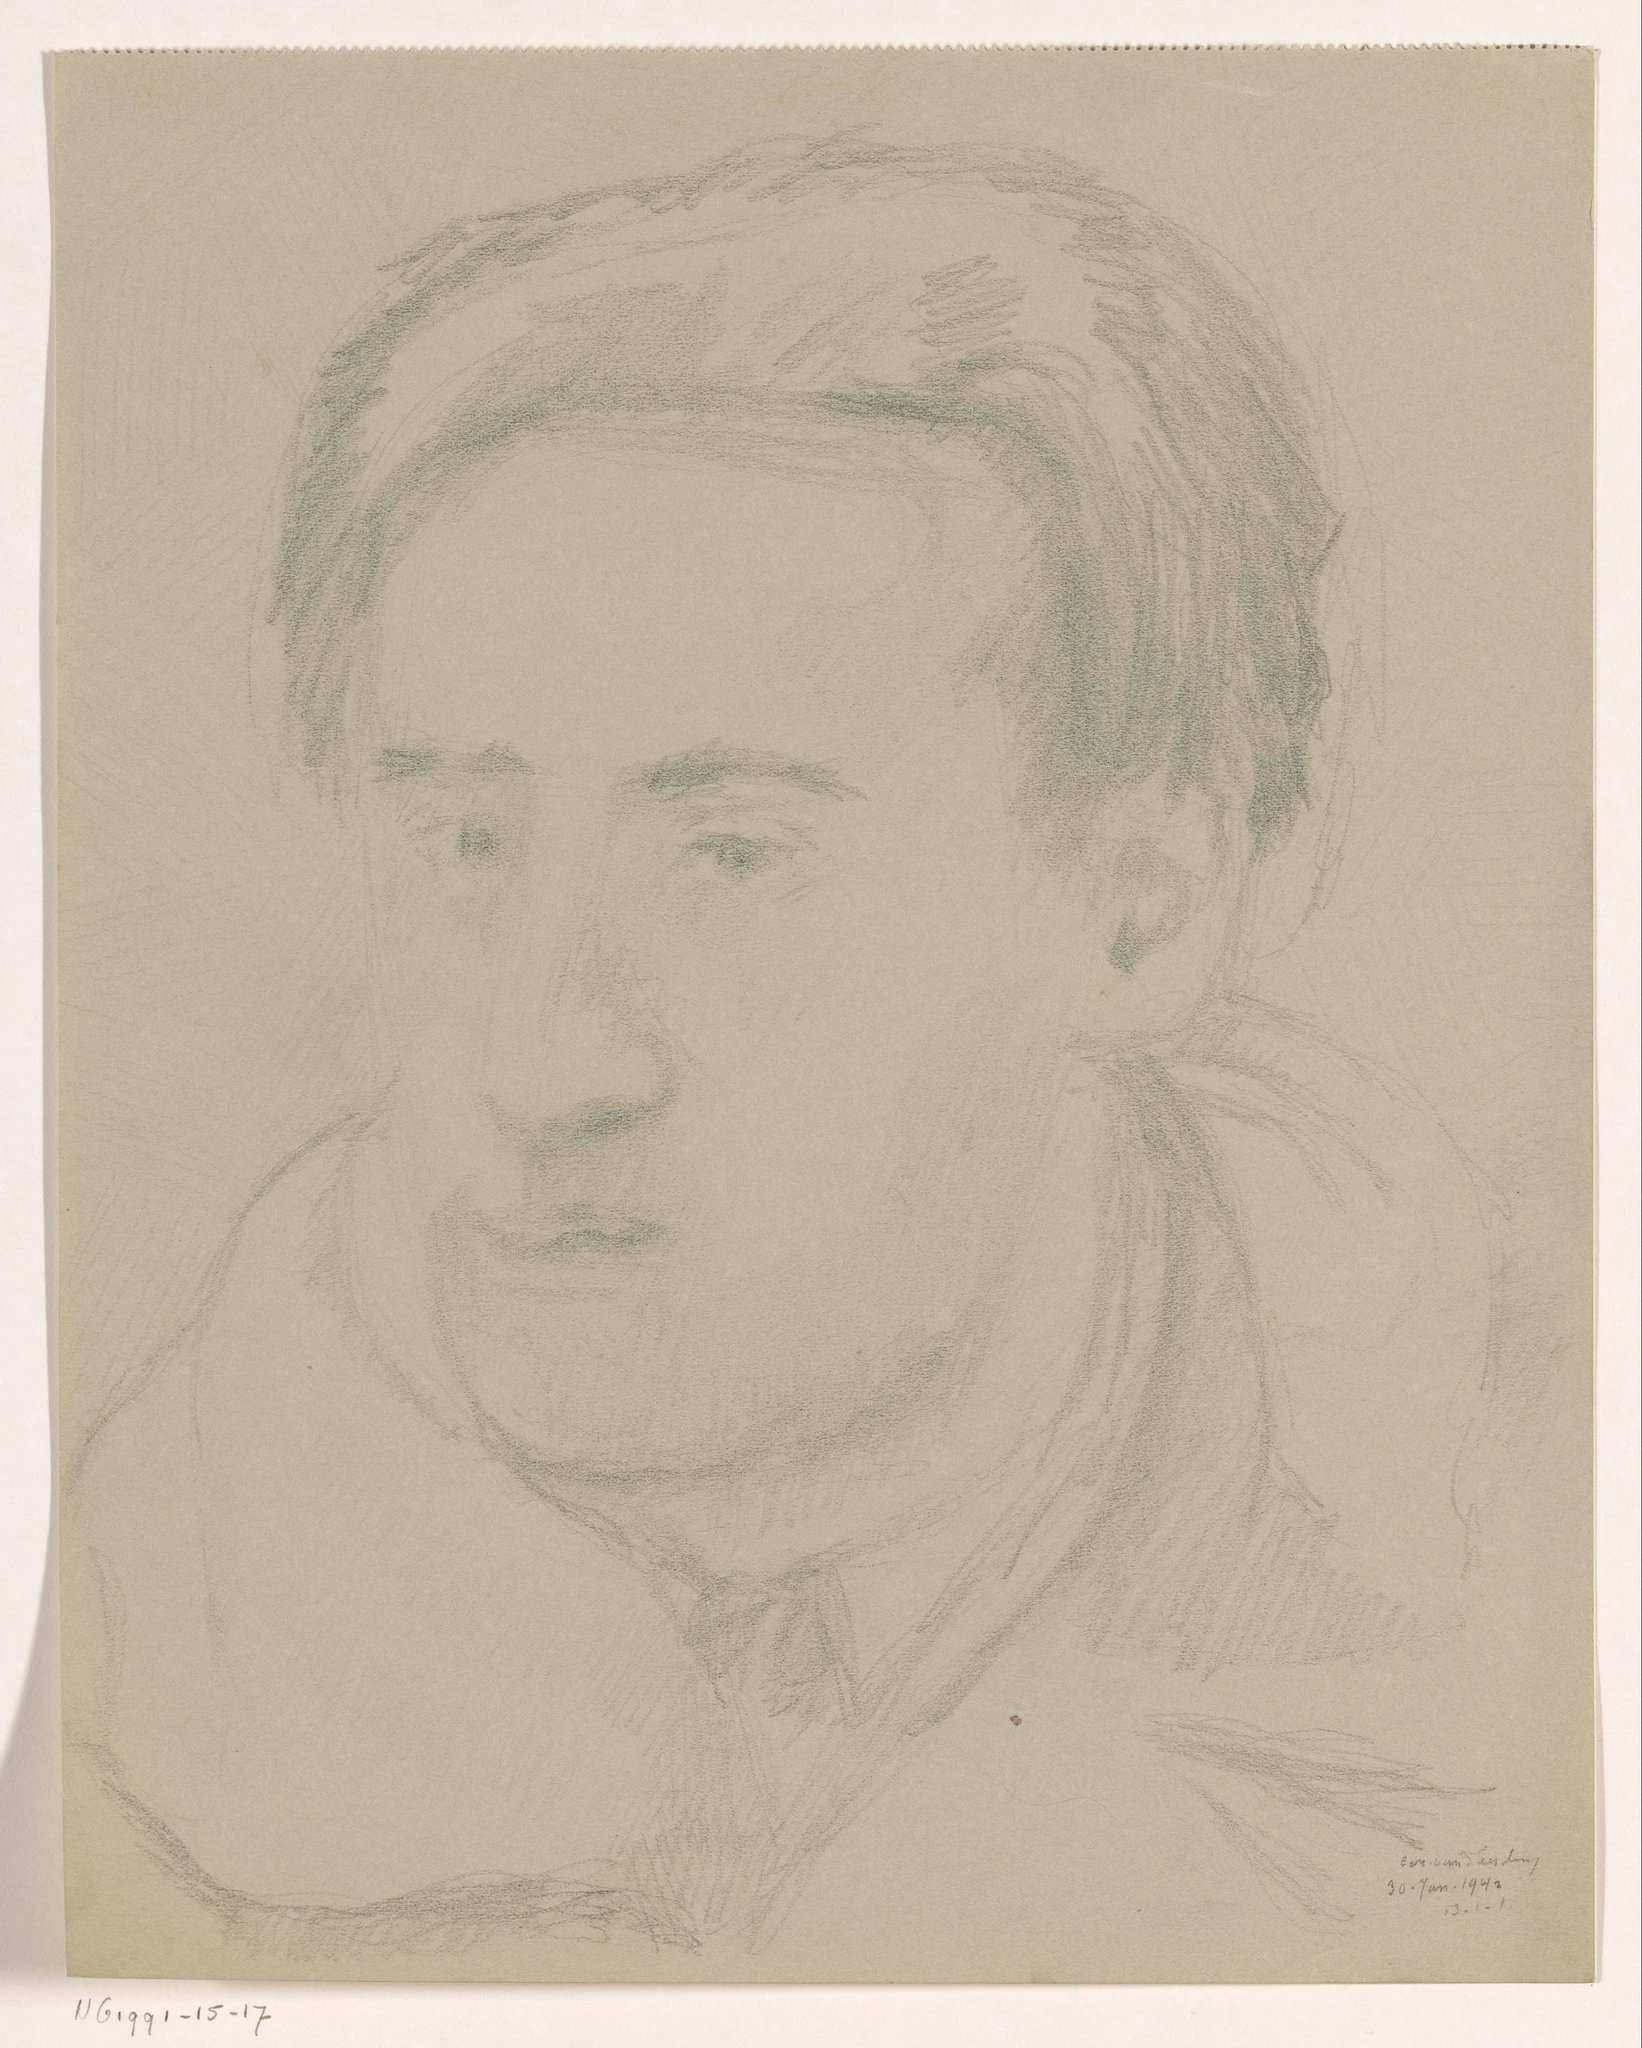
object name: drawing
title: Zelfportret: B-1-1, 30 januari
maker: cor van teeseling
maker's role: draughtsman, sculptor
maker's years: 1915-1942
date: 1942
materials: paper, pencil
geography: weteringschans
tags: amsterdam, draughtsman, sculptor, cor van teeseling, historical persons, prisoner in cell or locked place, portrait, self-portrait of draughtsman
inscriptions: signature and date: ‘30 Jan 1942 / Cor van Teeseling / B-1-1’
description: Zelfportret van Cor van Teeseling: gevangenis aan Weteringschans, cel B-1-1, 30 januari. Getekend zelfportret van Cor van Teeseling met zijn hoofd naar rechts gewend.